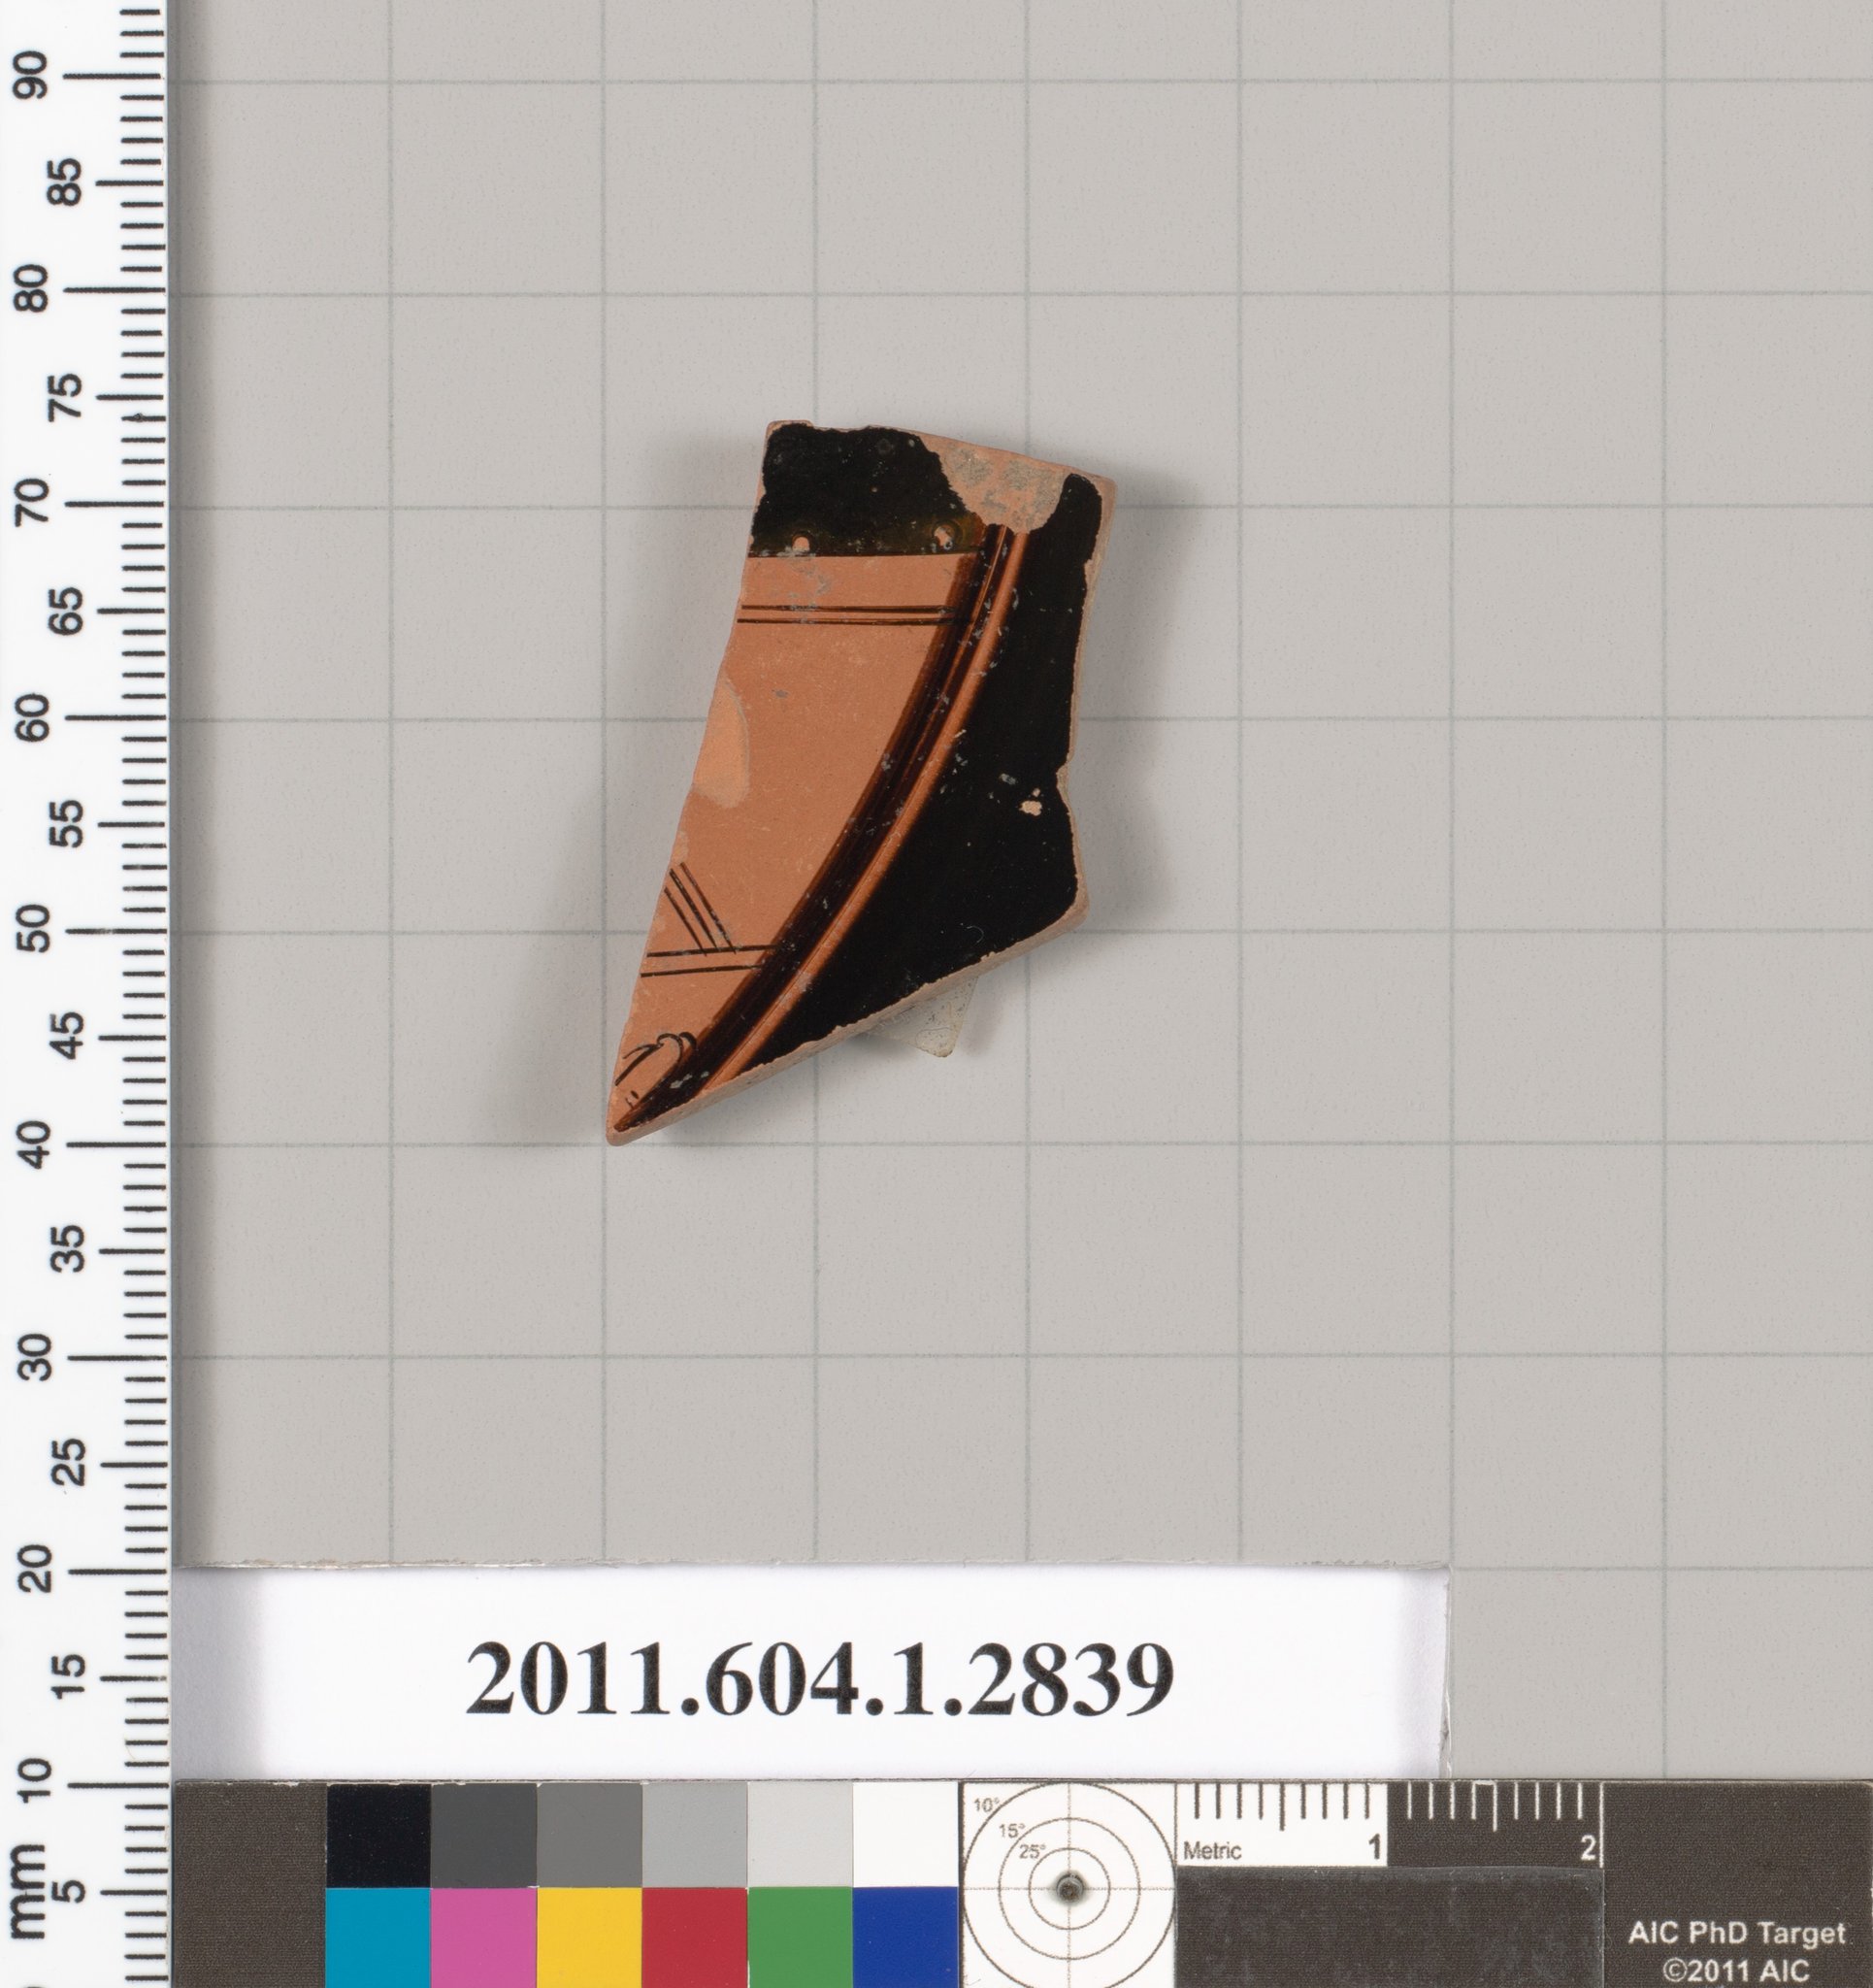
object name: kylix fragment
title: Terracotta fragment of a kylix (drinking cup)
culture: greek, attic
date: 510-480 BCE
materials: terracotta